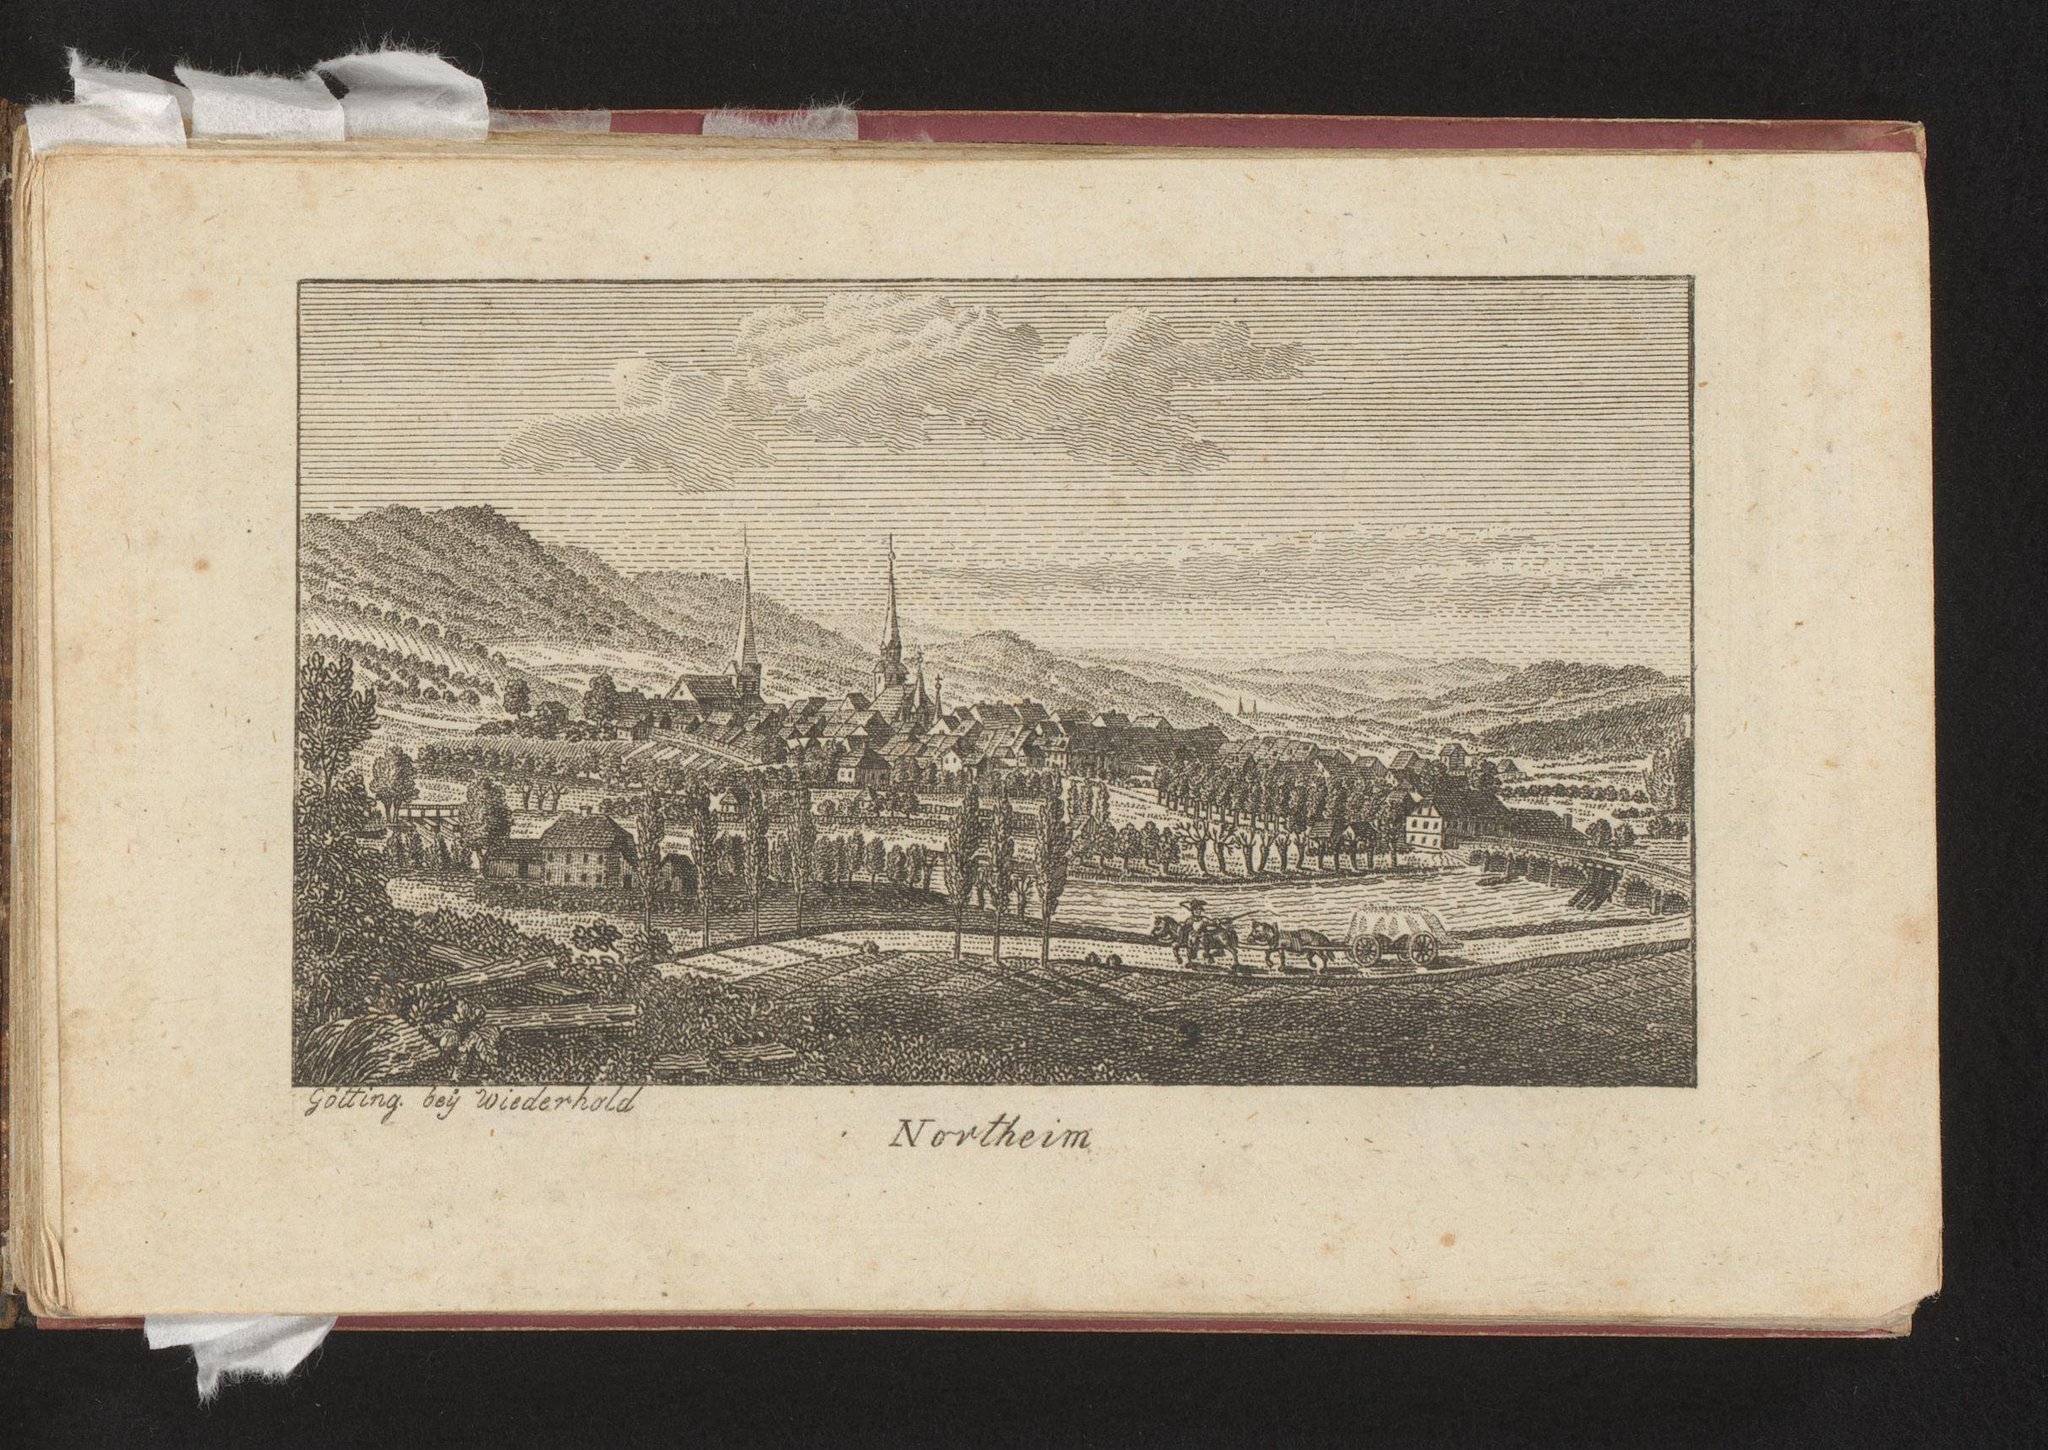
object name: print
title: Northeim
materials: ink, paper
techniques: etching, writing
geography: gottingen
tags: prospect of village, silhouette of village, 'album amicorum', 'stammbuch'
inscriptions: tekst, verso, handgeschreven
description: Handgeschreven tekst in het Duits op het verso.